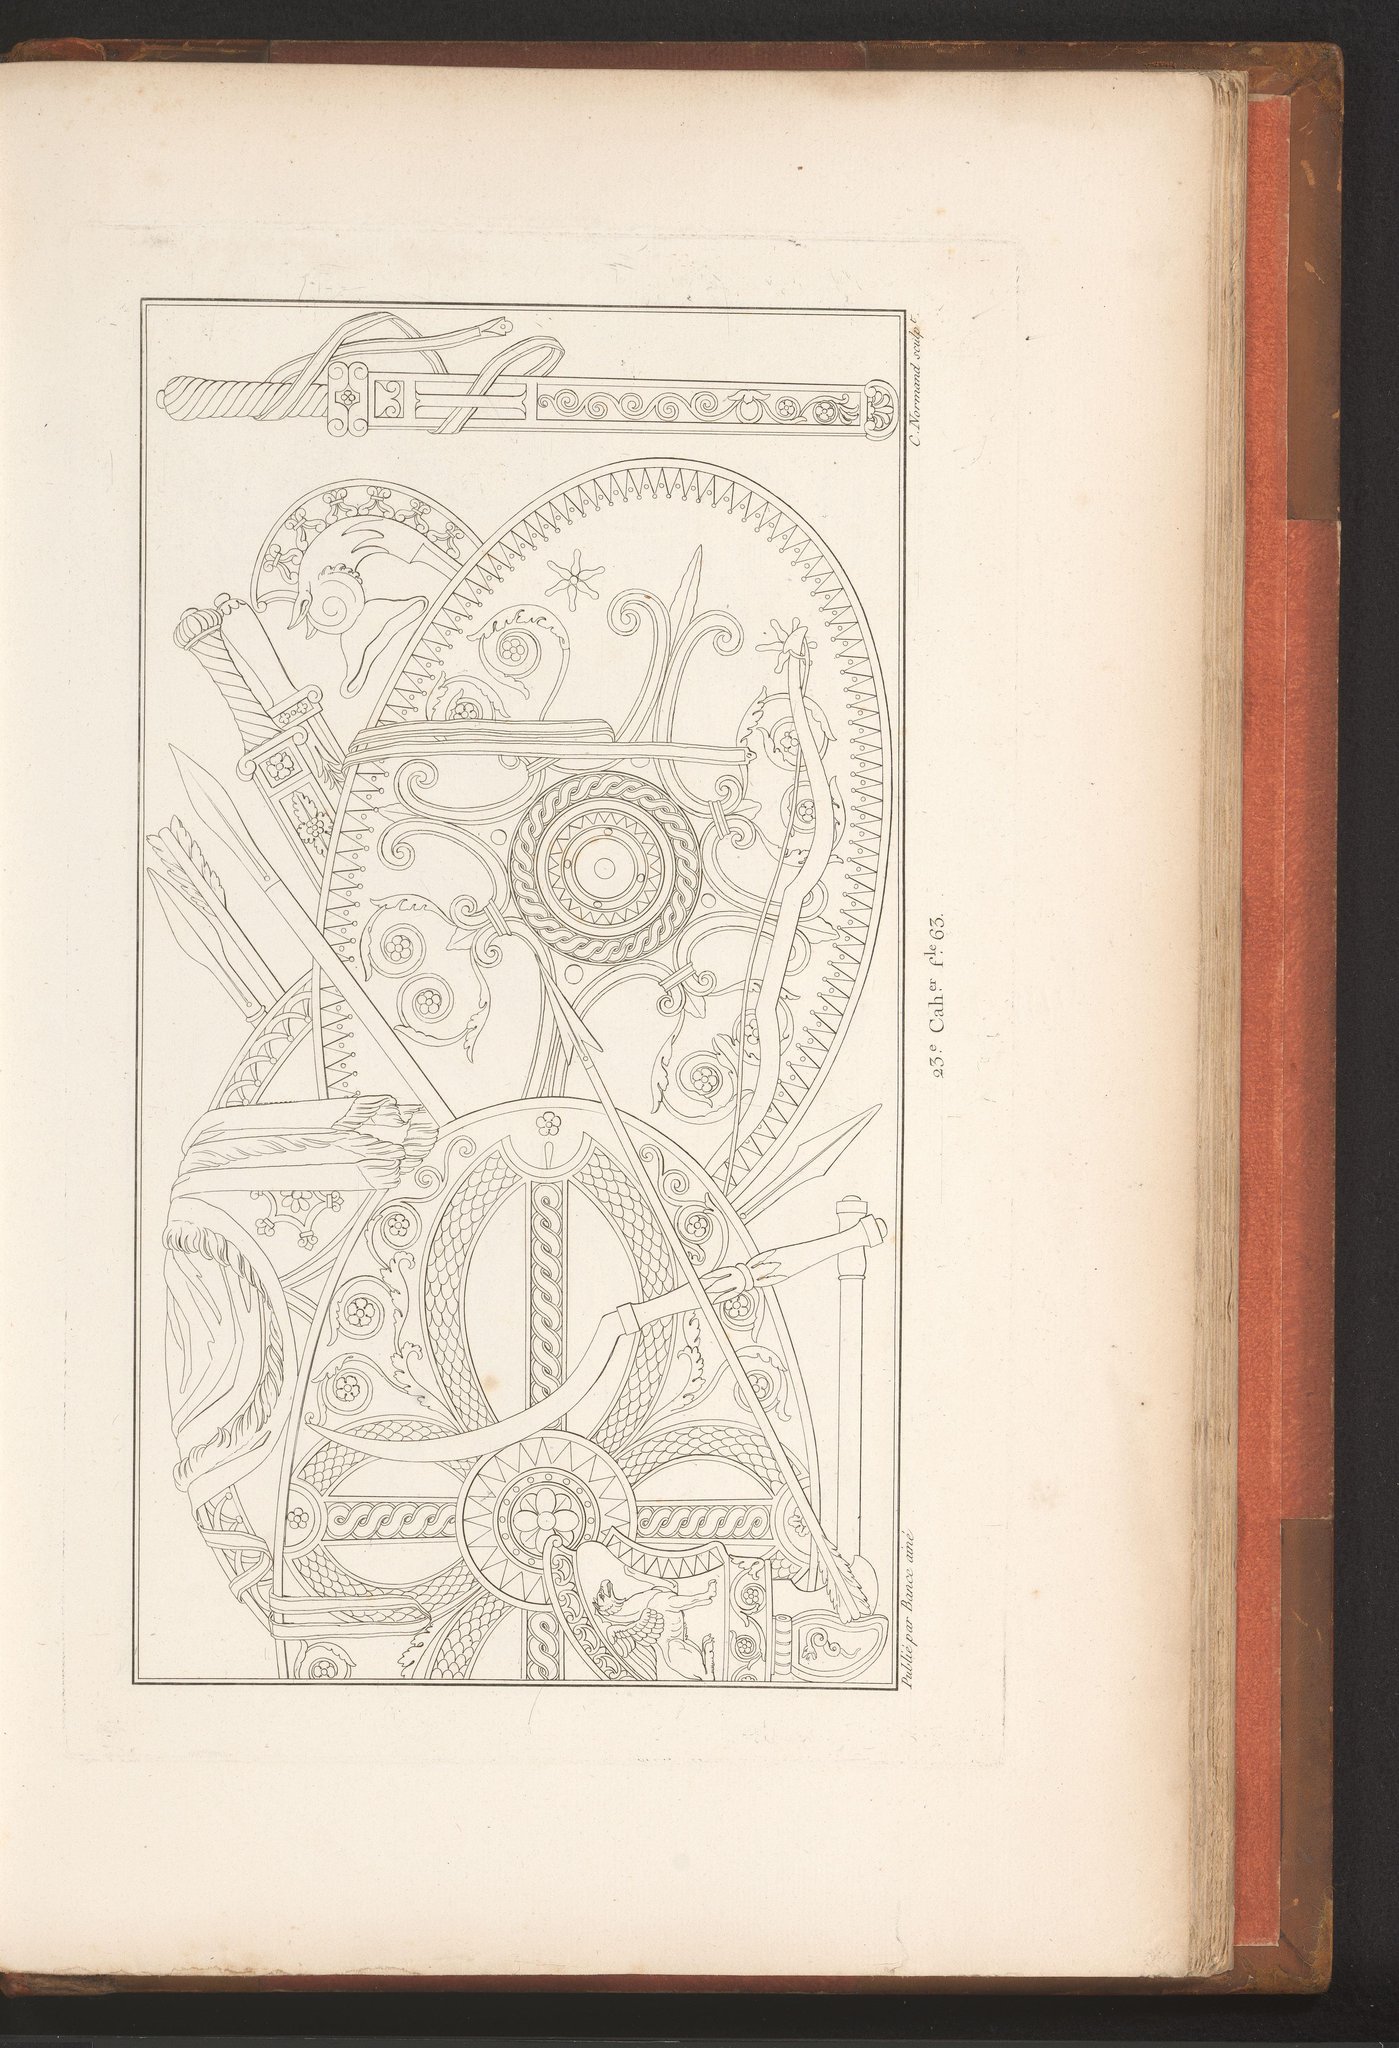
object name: ornament print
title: Wapentrofee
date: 1820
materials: paper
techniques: etching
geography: paris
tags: ornaments ~ art, 'tropaion', i.e. decorative ornament ~ weapons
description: Wapentrofee, ornament met wapens en wapenrusting, overgenomen van de Zuil van Trajanus. Onderdeel (23e. Cah.er f.le 63) van het prentalbum met twee series van in totaal 138 ornamentprenten door Beauvallet en Normand, 'Fragmens d'Ornemens dans le Style Antique'.